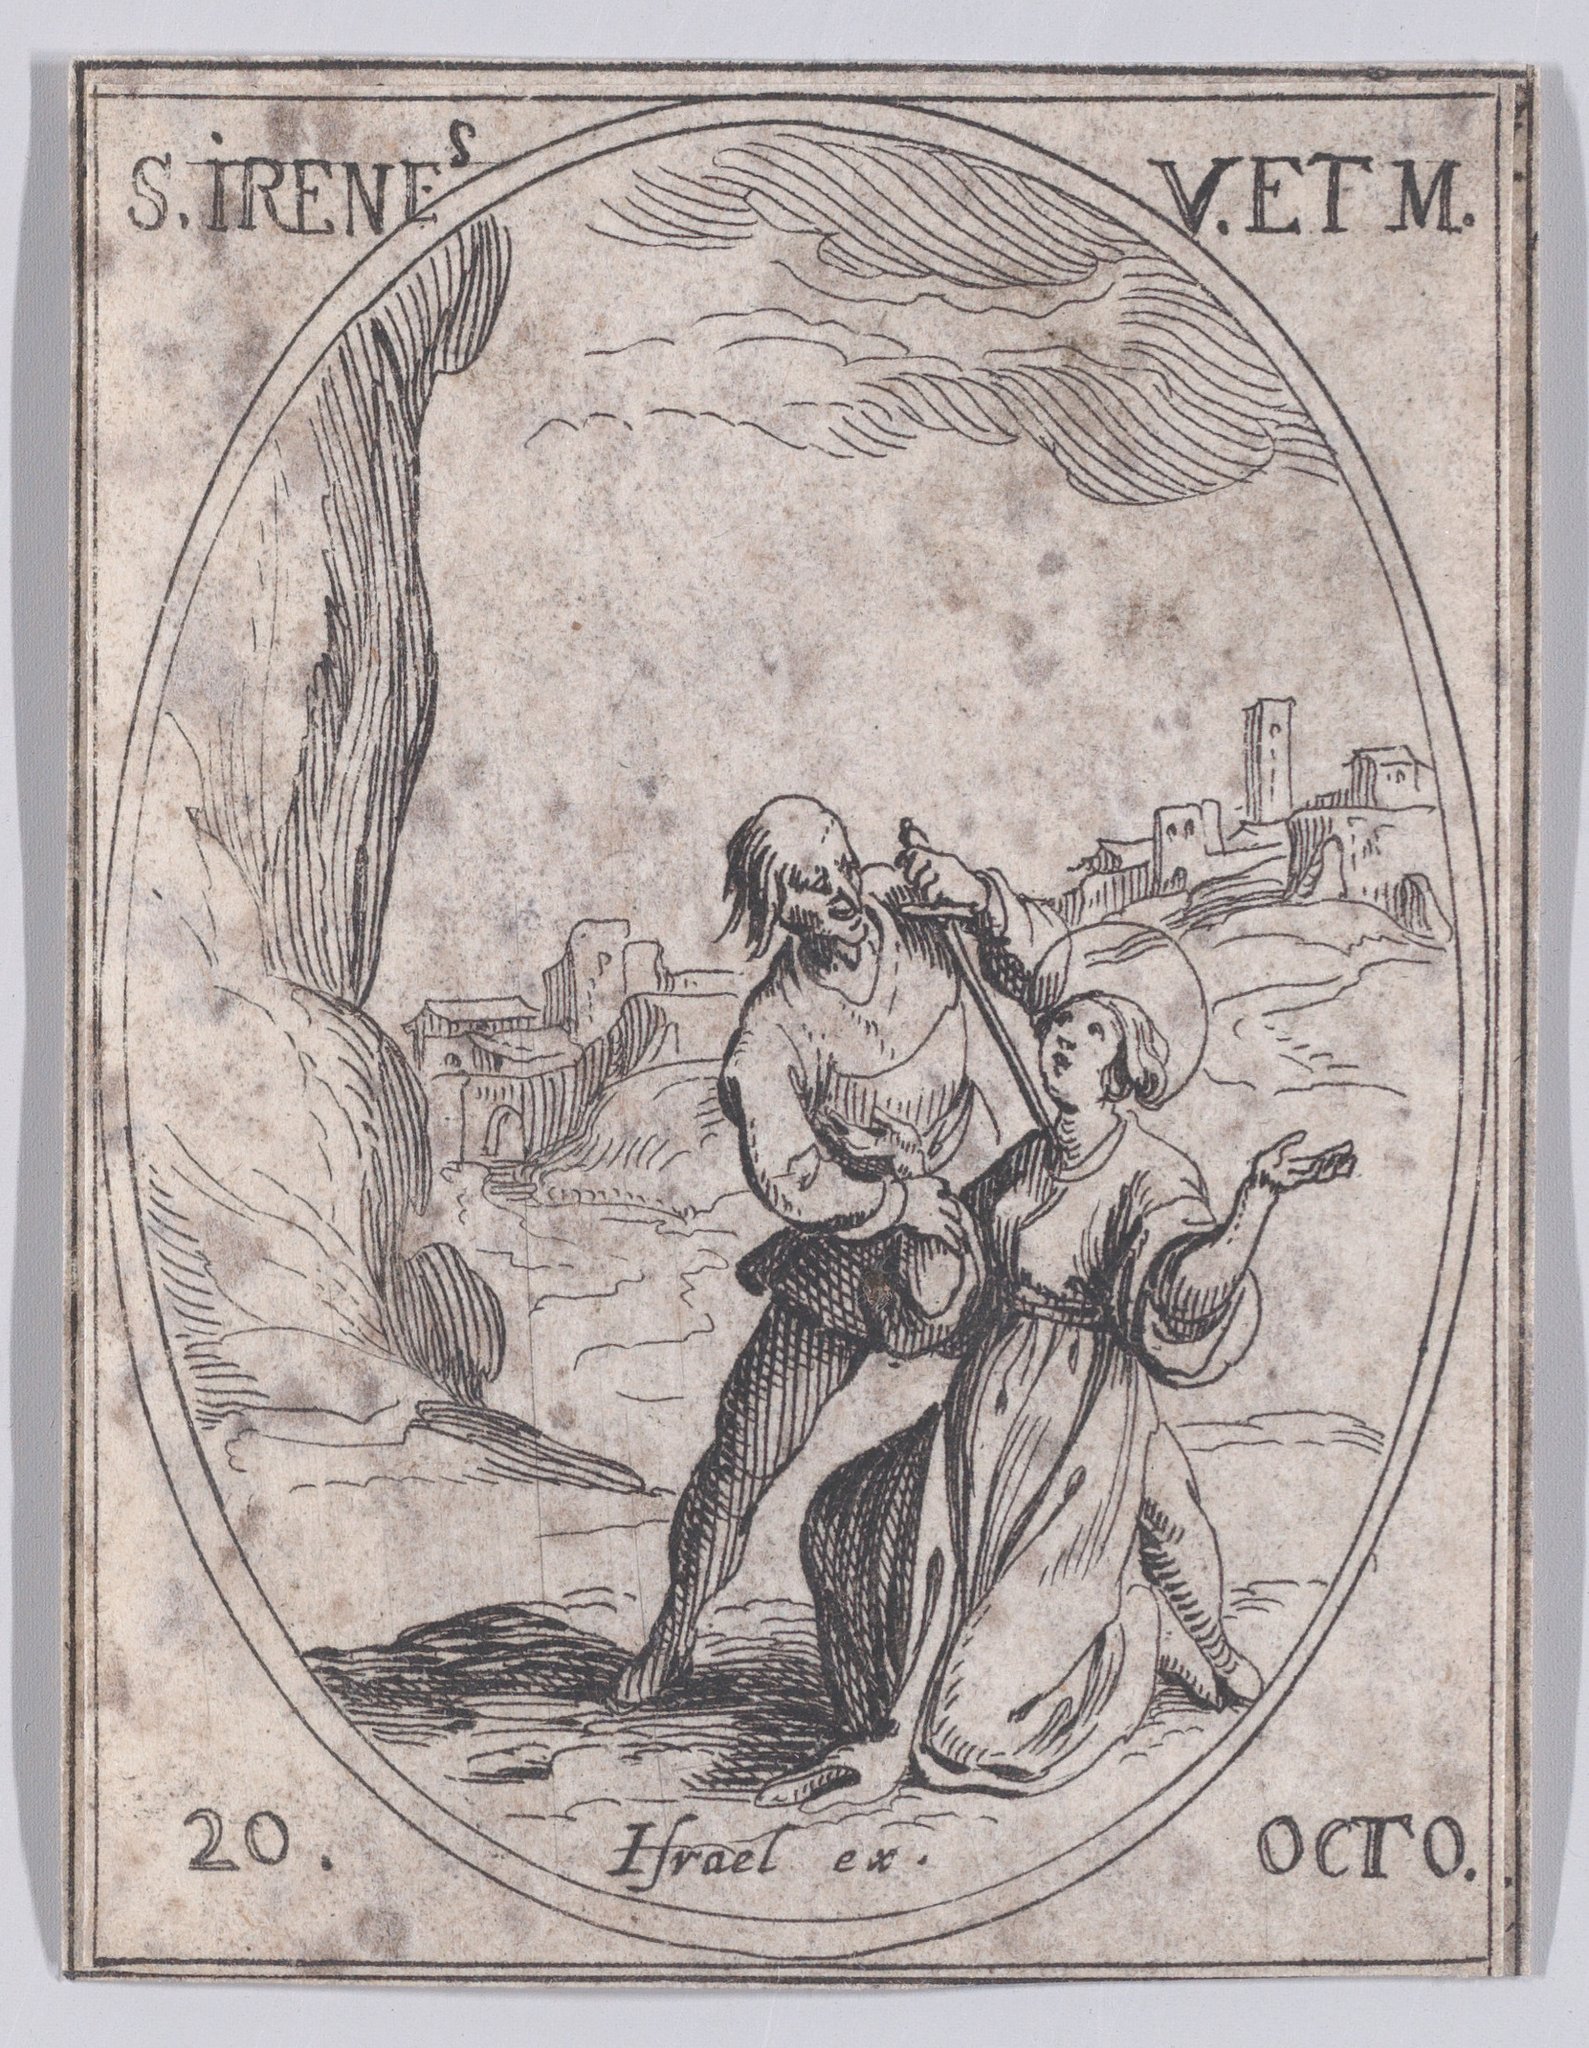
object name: print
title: Ste. Irène, vierge et martyre (St. Irene, Virgin and Martyr), October 20th, from "Les Images De Tous Les Saincts et Saintes de L'Année" (Images of All of the Saints and Religious Events of the Year)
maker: jacques callot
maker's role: artist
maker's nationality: french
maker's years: 1592-1635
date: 1636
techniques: etching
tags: men,women,saints